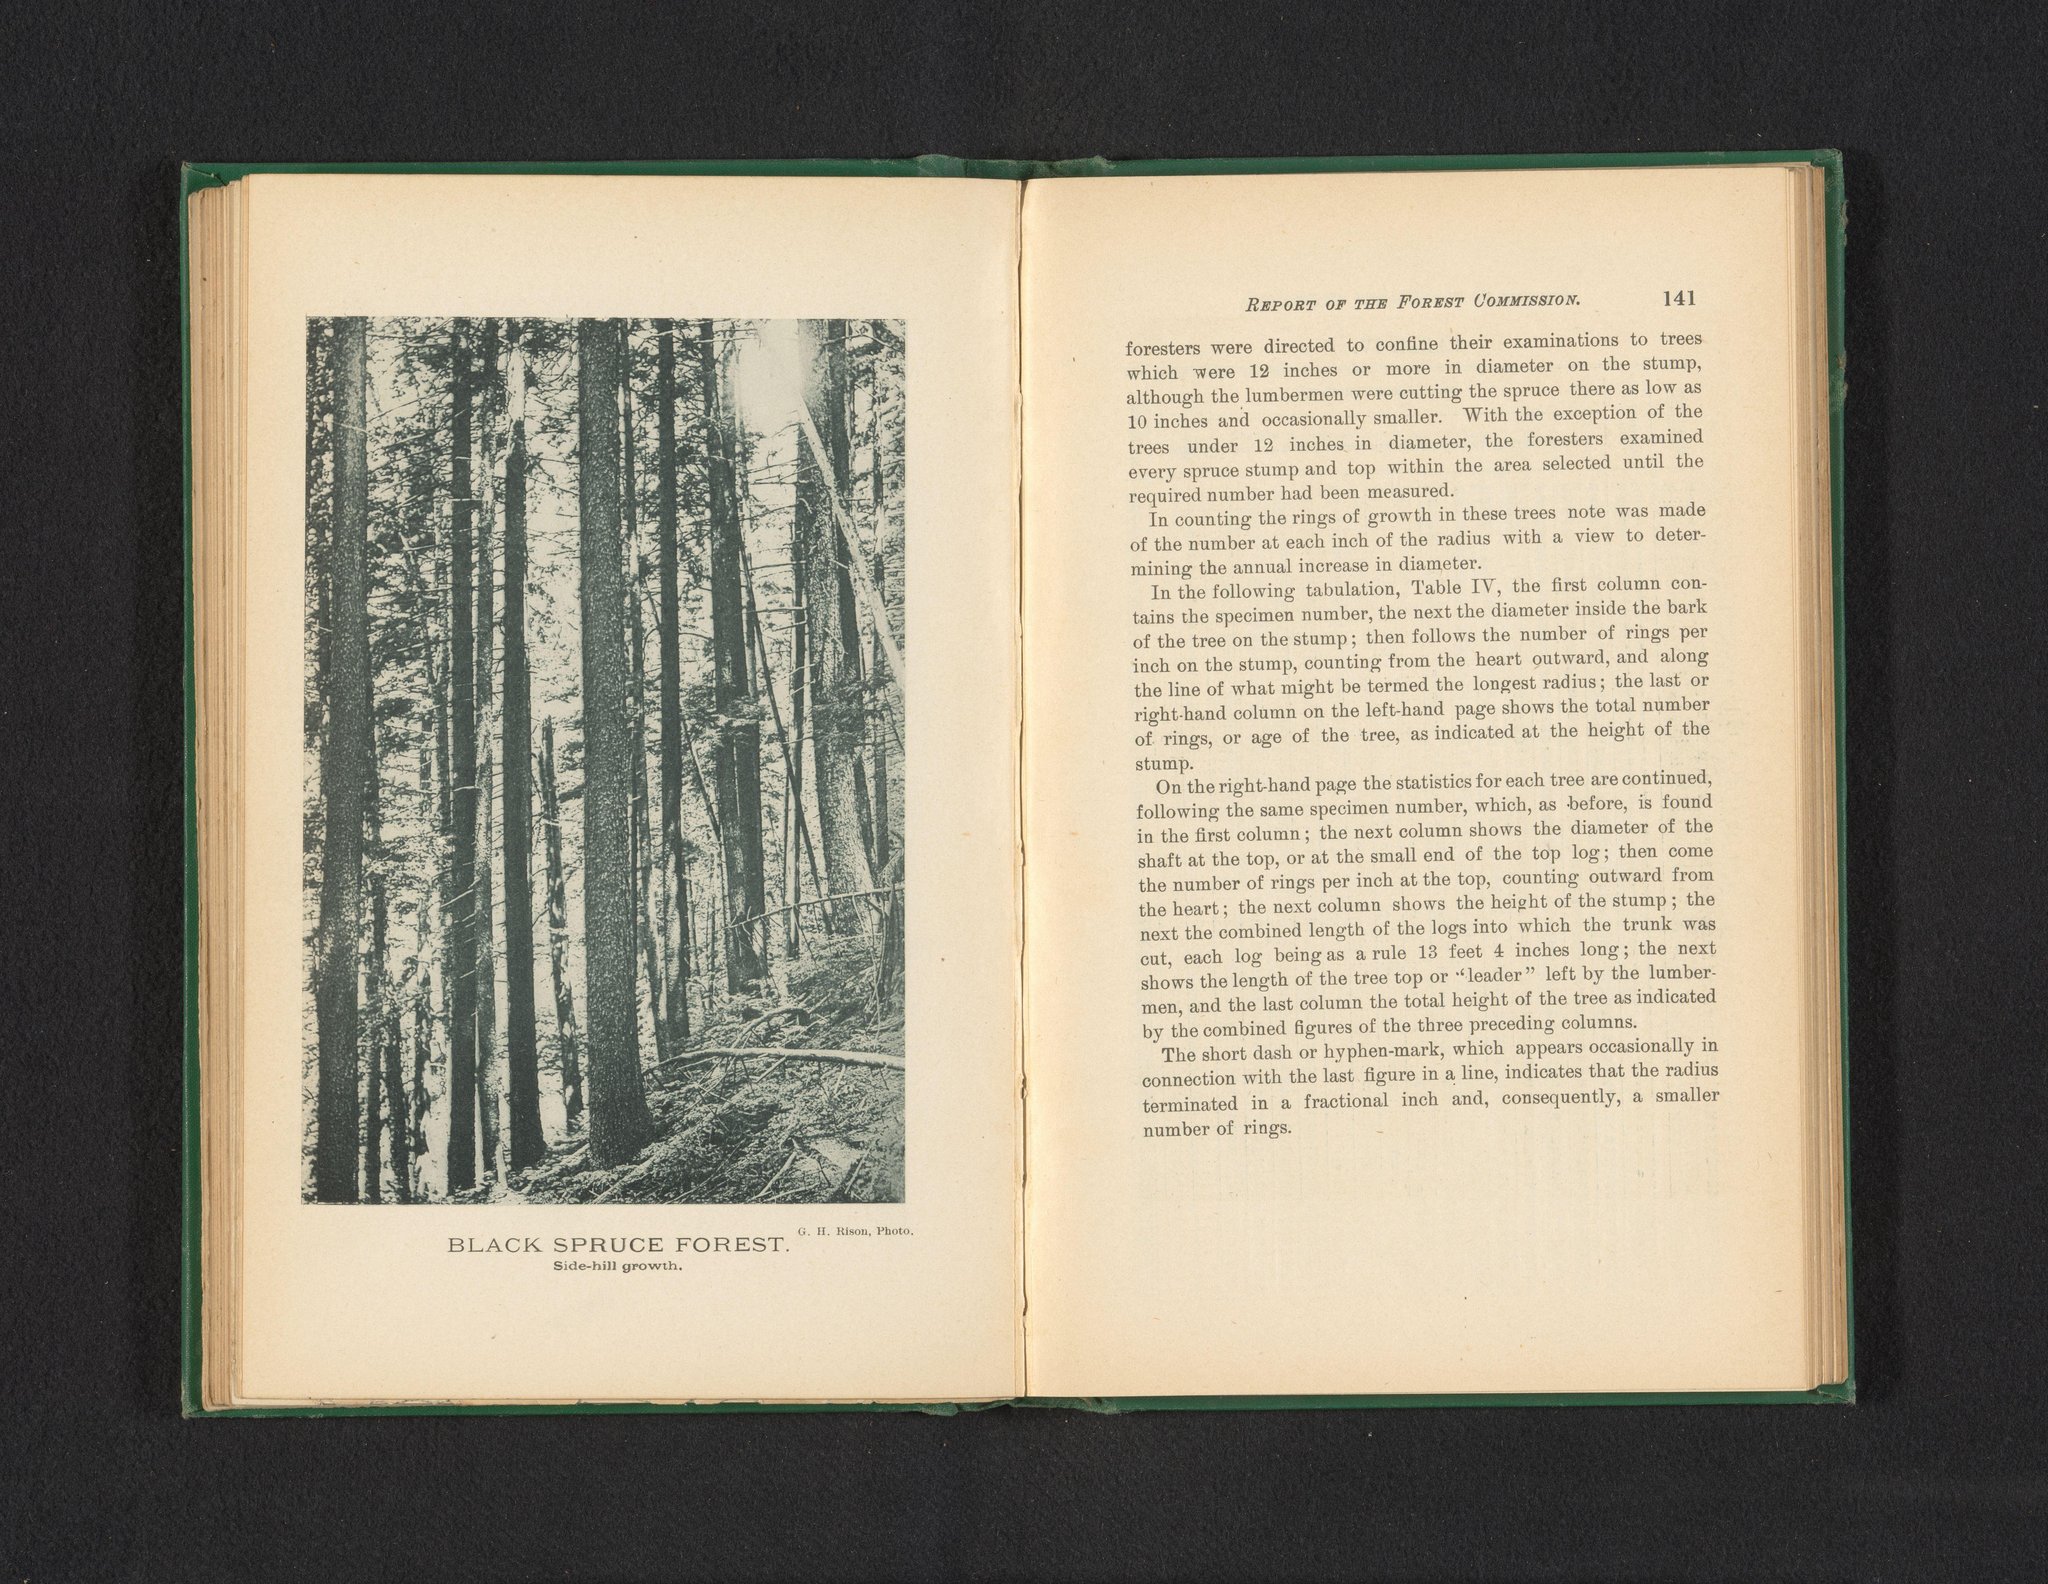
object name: photomechanical print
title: Black spruce forest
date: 1894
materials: paper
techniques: photograph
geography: new york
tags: trees: spruce, forest, wood